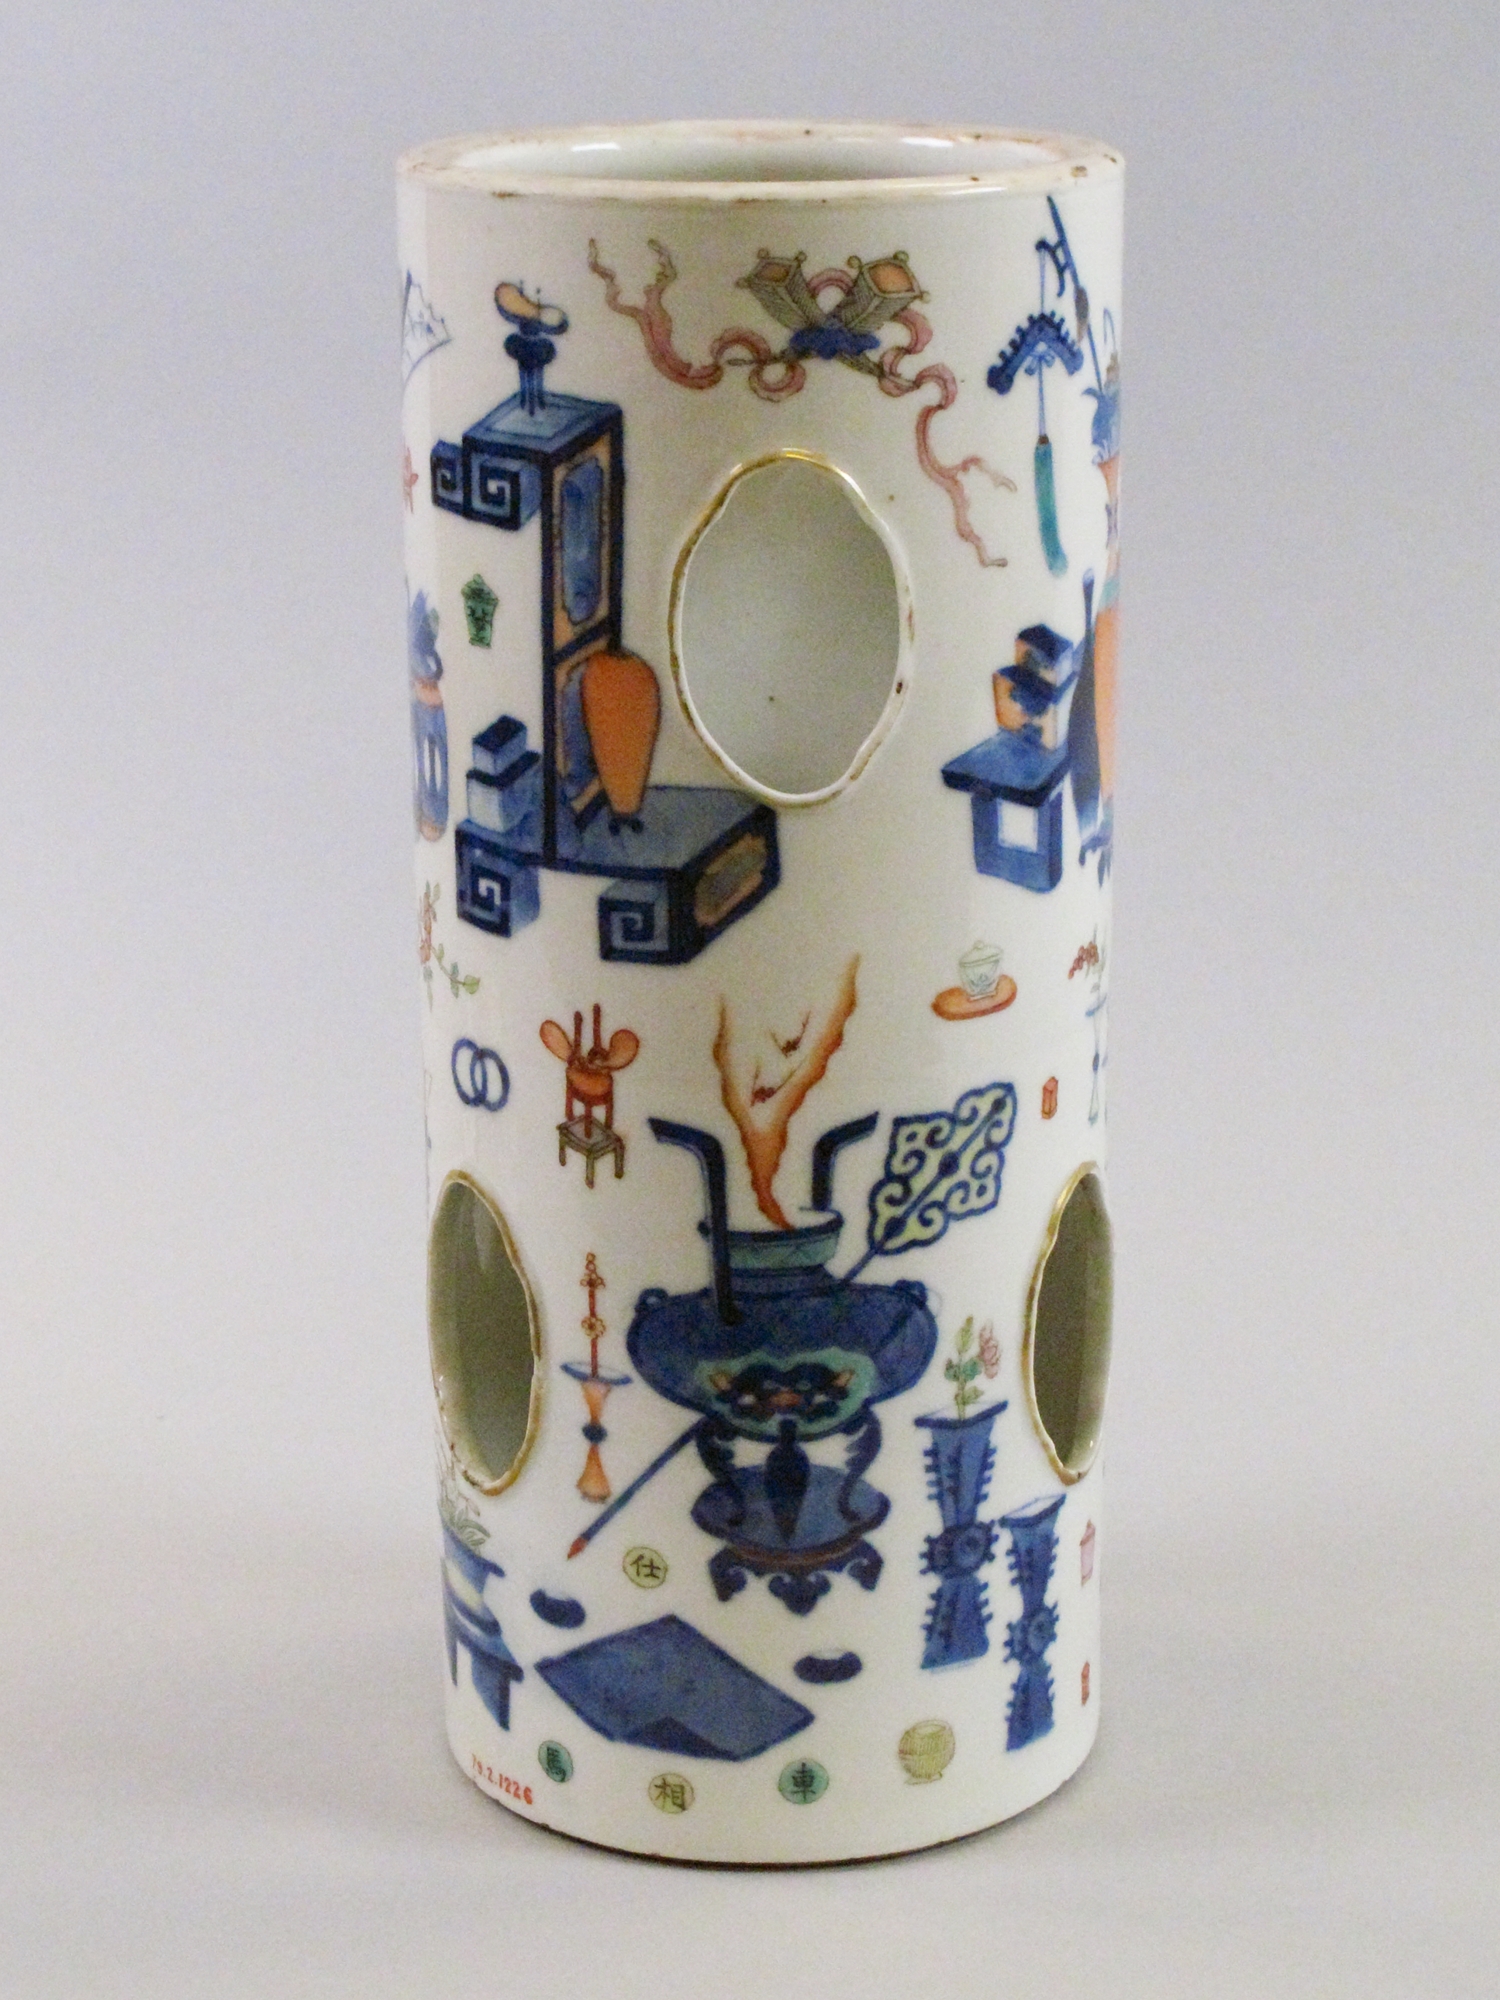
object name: brush holder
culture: chinese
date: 1736-1795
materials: enamel, porcelain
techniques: overglaze, painting, polychrome, underglaze